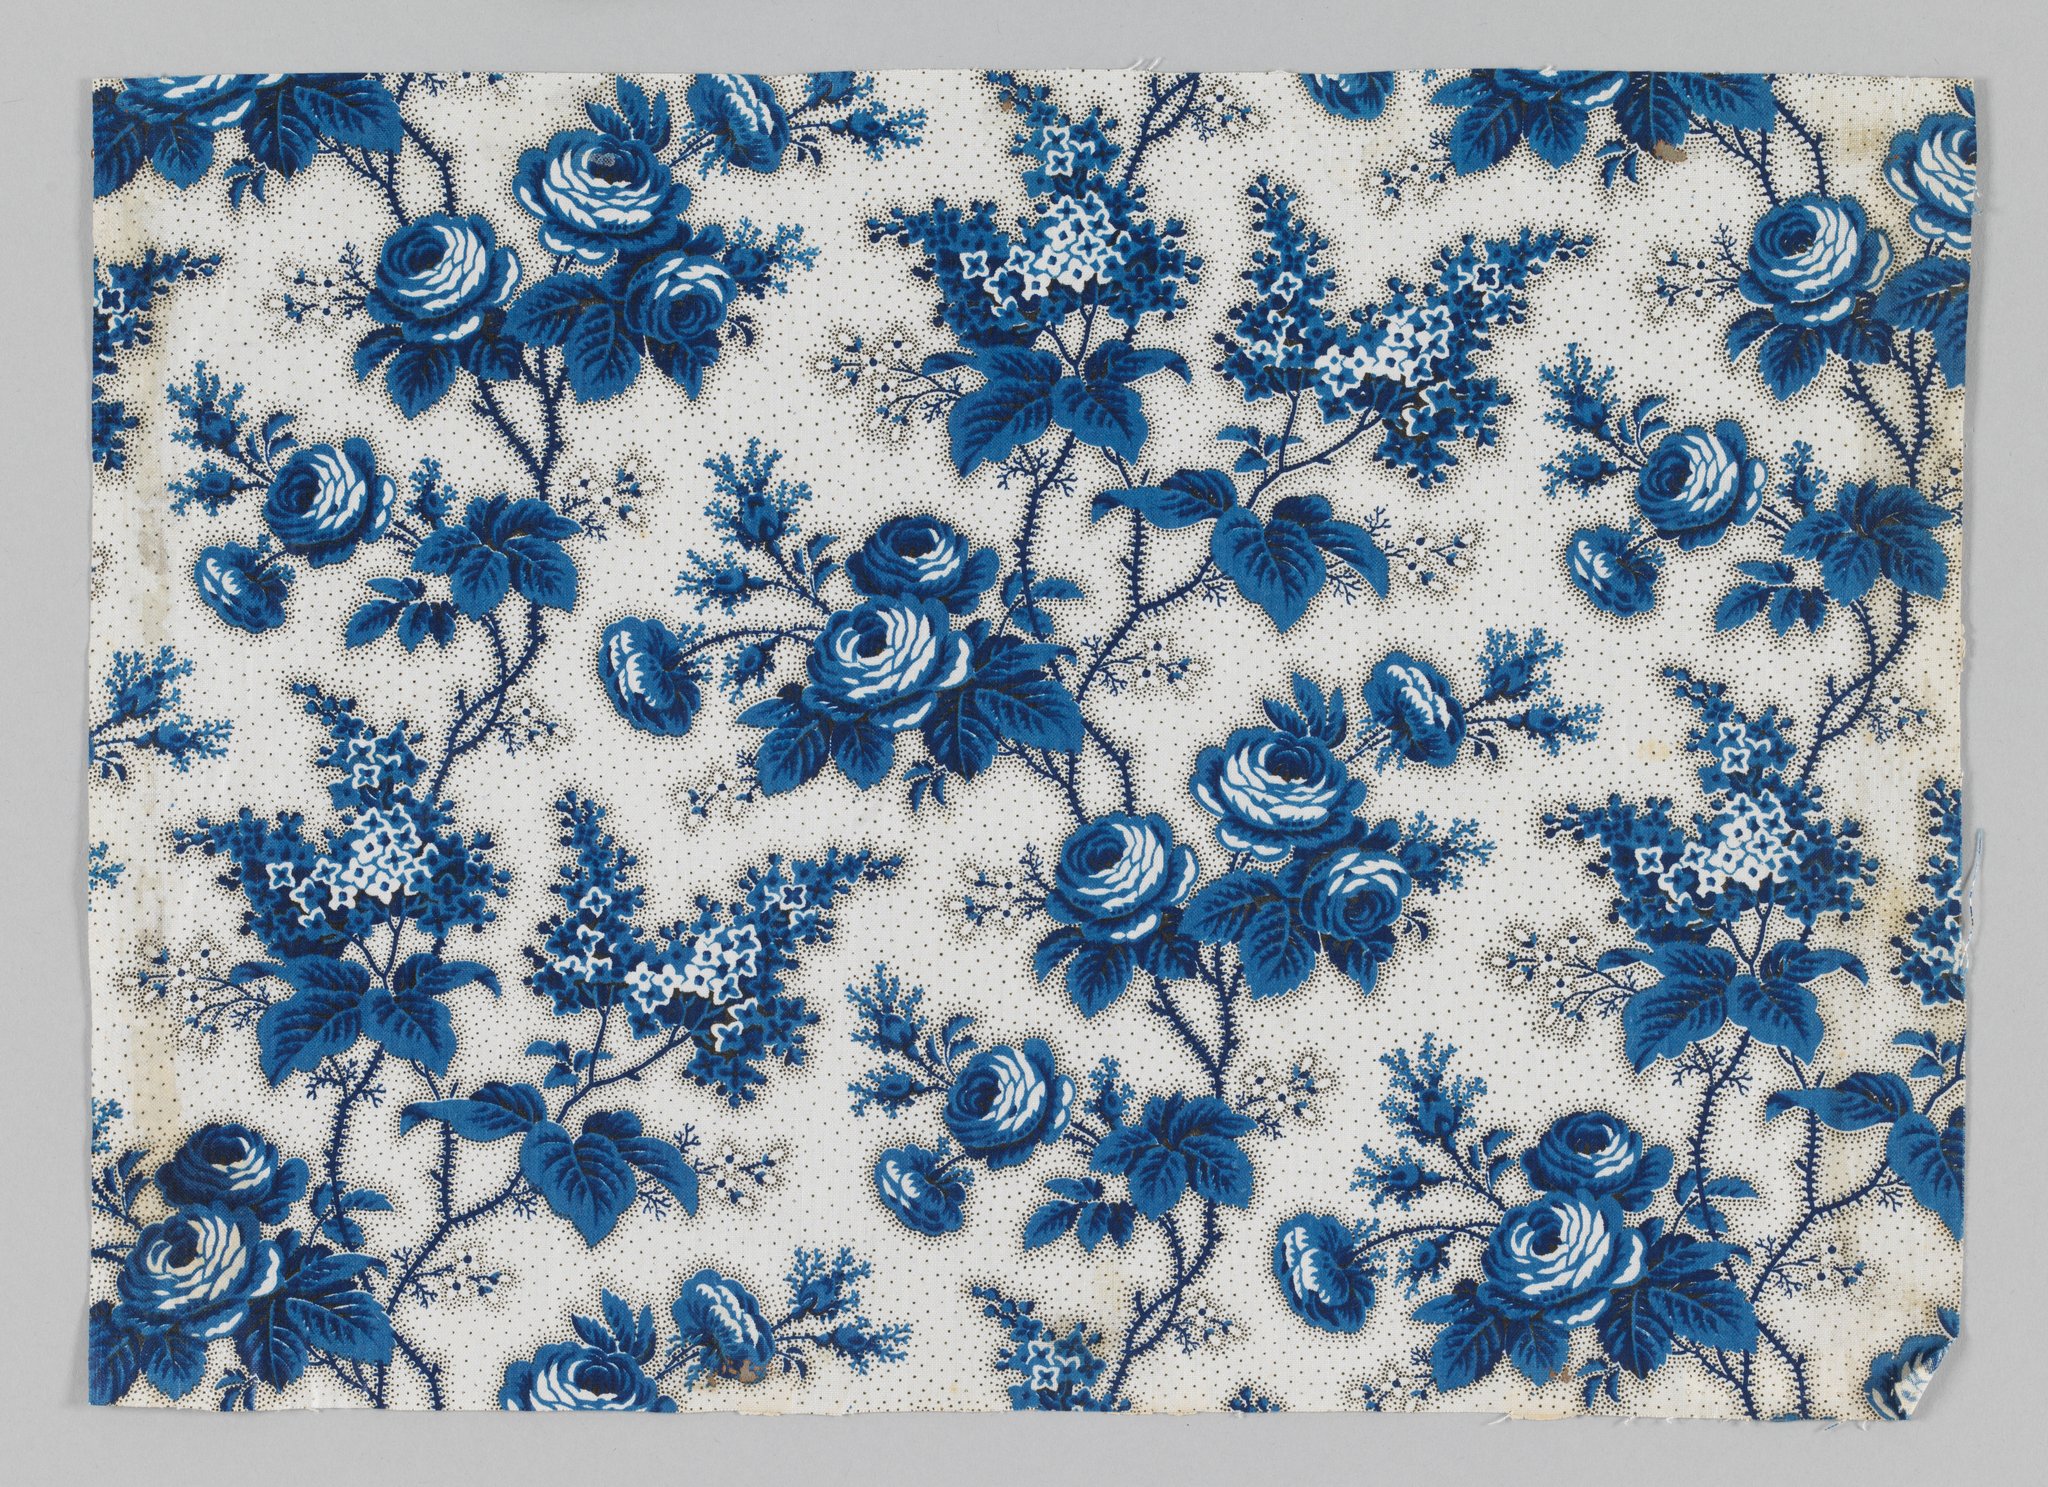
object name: piece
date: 1801-1900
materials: cotton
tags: roses